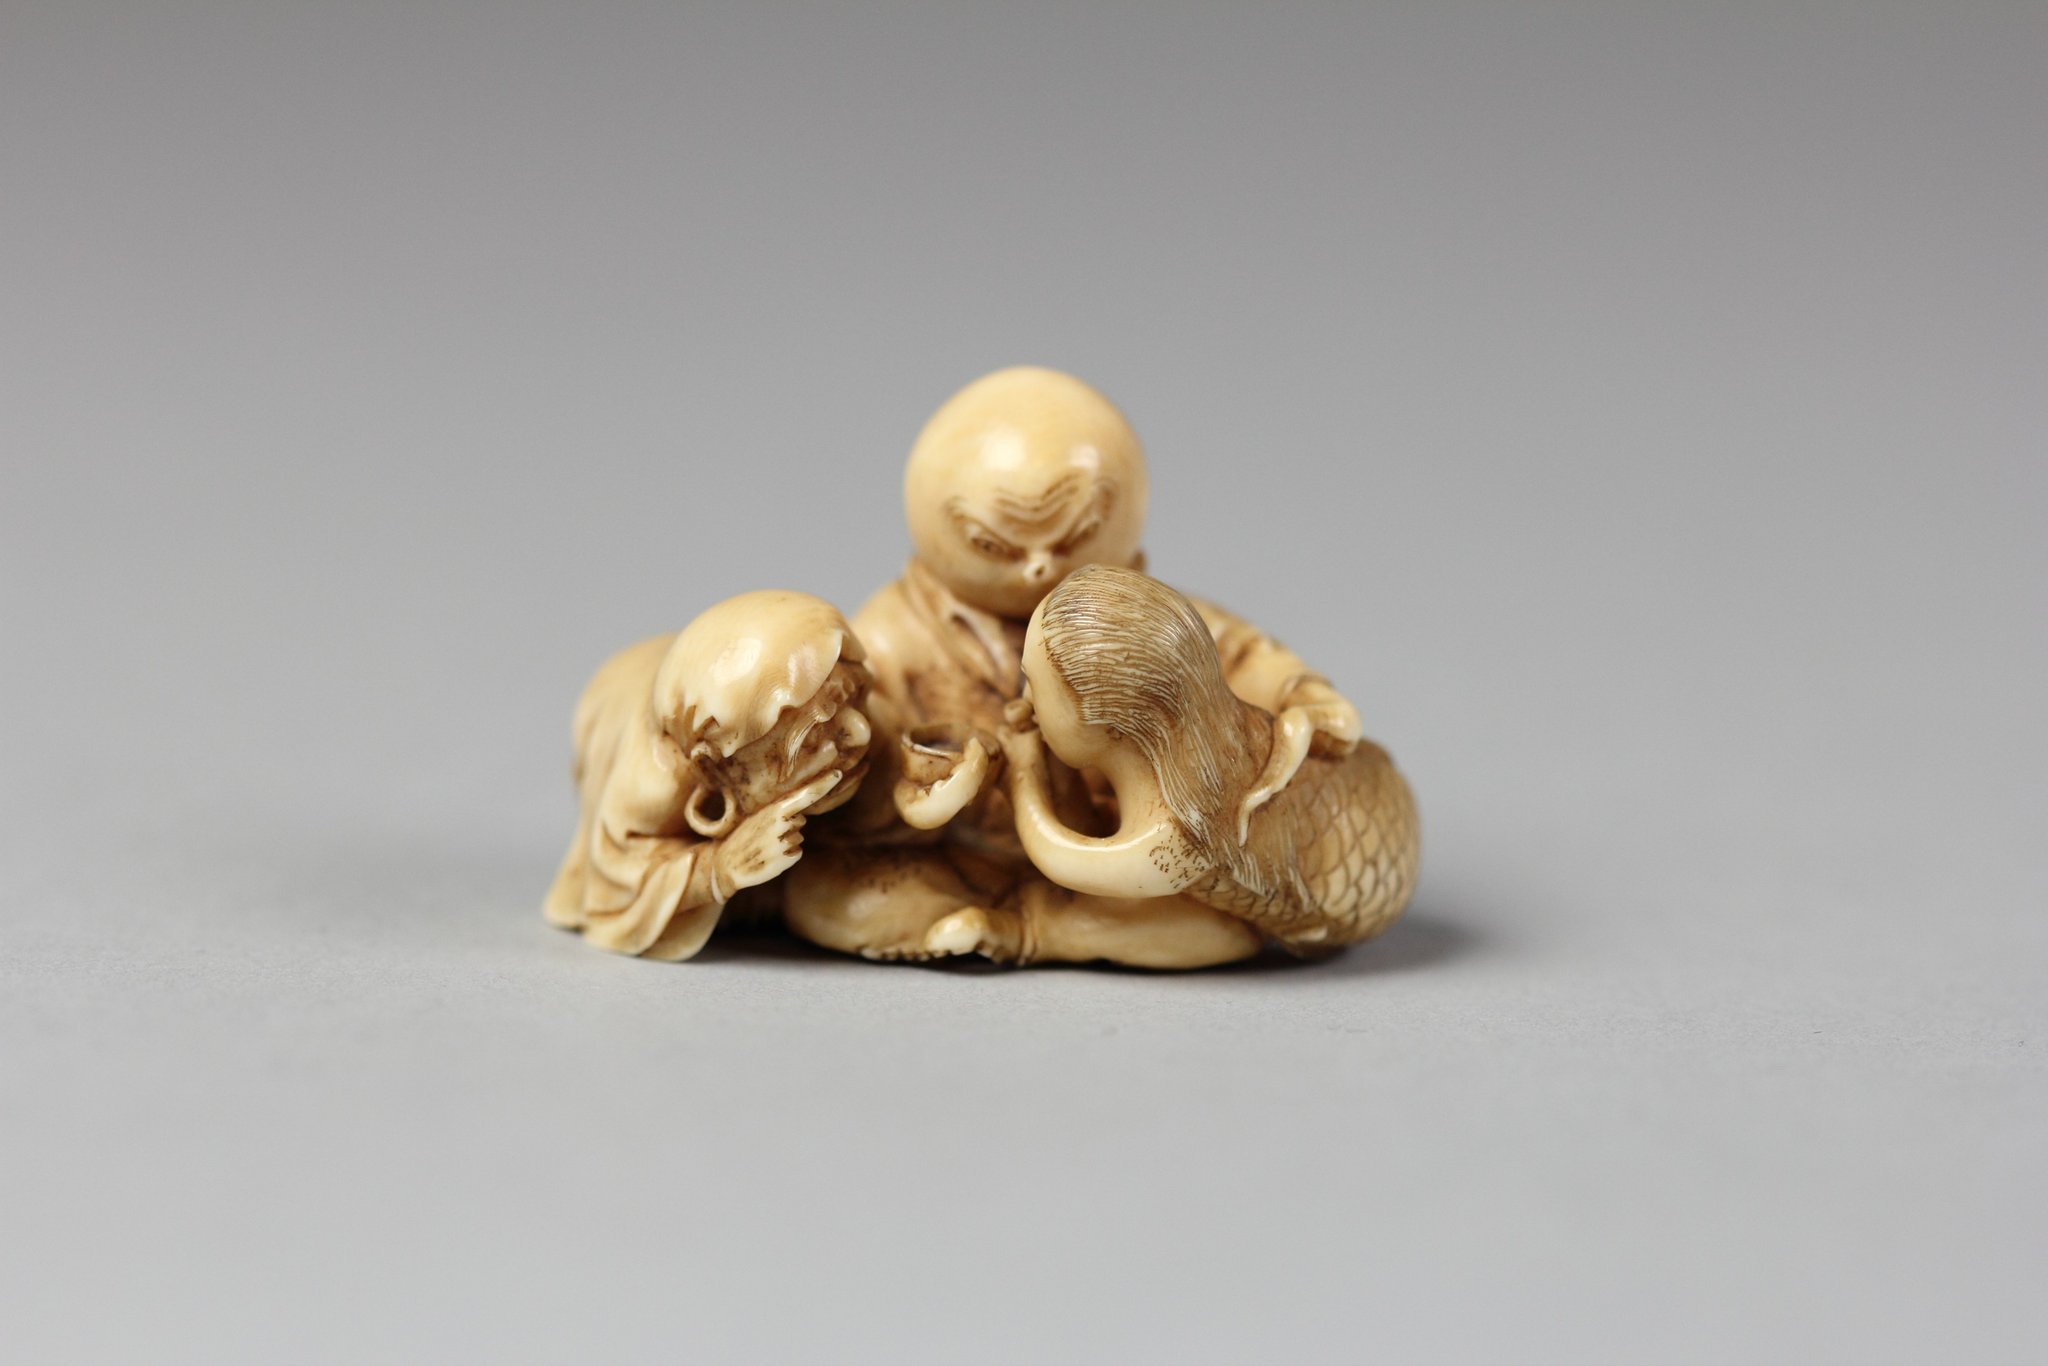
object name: netsuke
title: Netsuke of Daruma Admonishing a Mermaid Serving Sake to an Octopus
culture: japanese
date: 1801-1900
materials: ivory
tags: mermaids,octopus